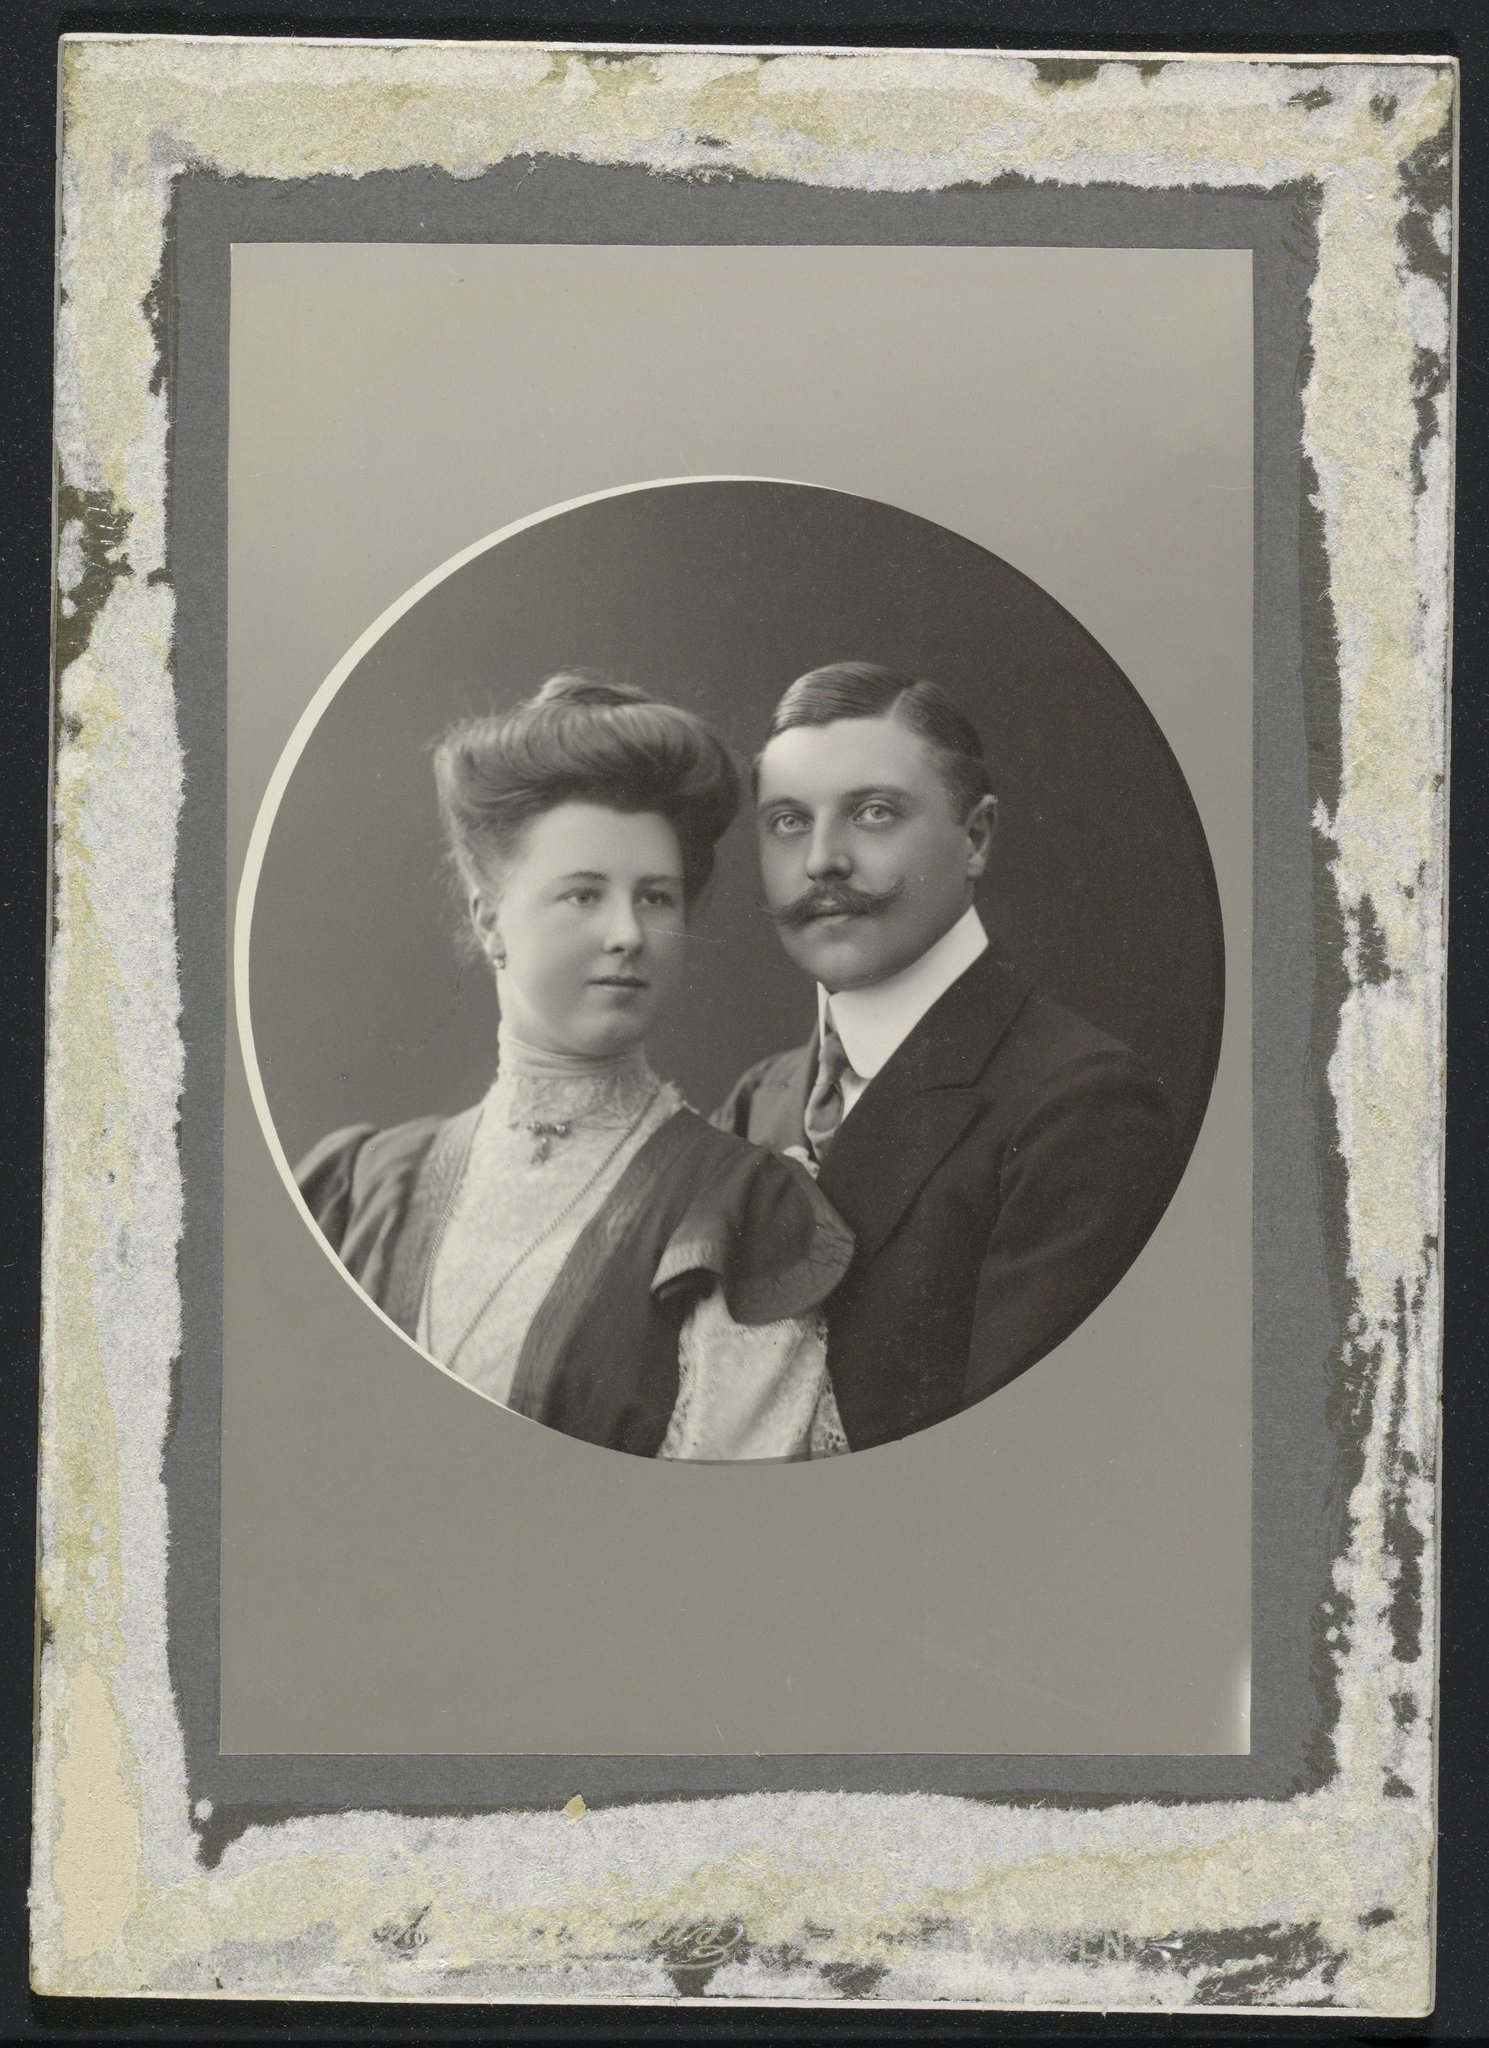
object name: photograph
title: Verlovings- of huwelijksportret van mevrouw M.C. Lucassen-Van Idsinga en de heer J. Lucassen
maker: Anonymous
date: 1907-1913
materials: cardboard, photographic support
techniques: matte daylight collodion silver print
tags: marriage, married couple, 'matrimonium'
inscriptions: date: ‘Ca. 1907-ca.1913 (?)’, inscription: ‘Heer en mevrouw Lucassen-v.Idsinga’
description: Verlovings- of huwelijksportret van mevrouw Lucassen-Van Idsinga en de heer J. Lucassen. Rond uitgeknipt.